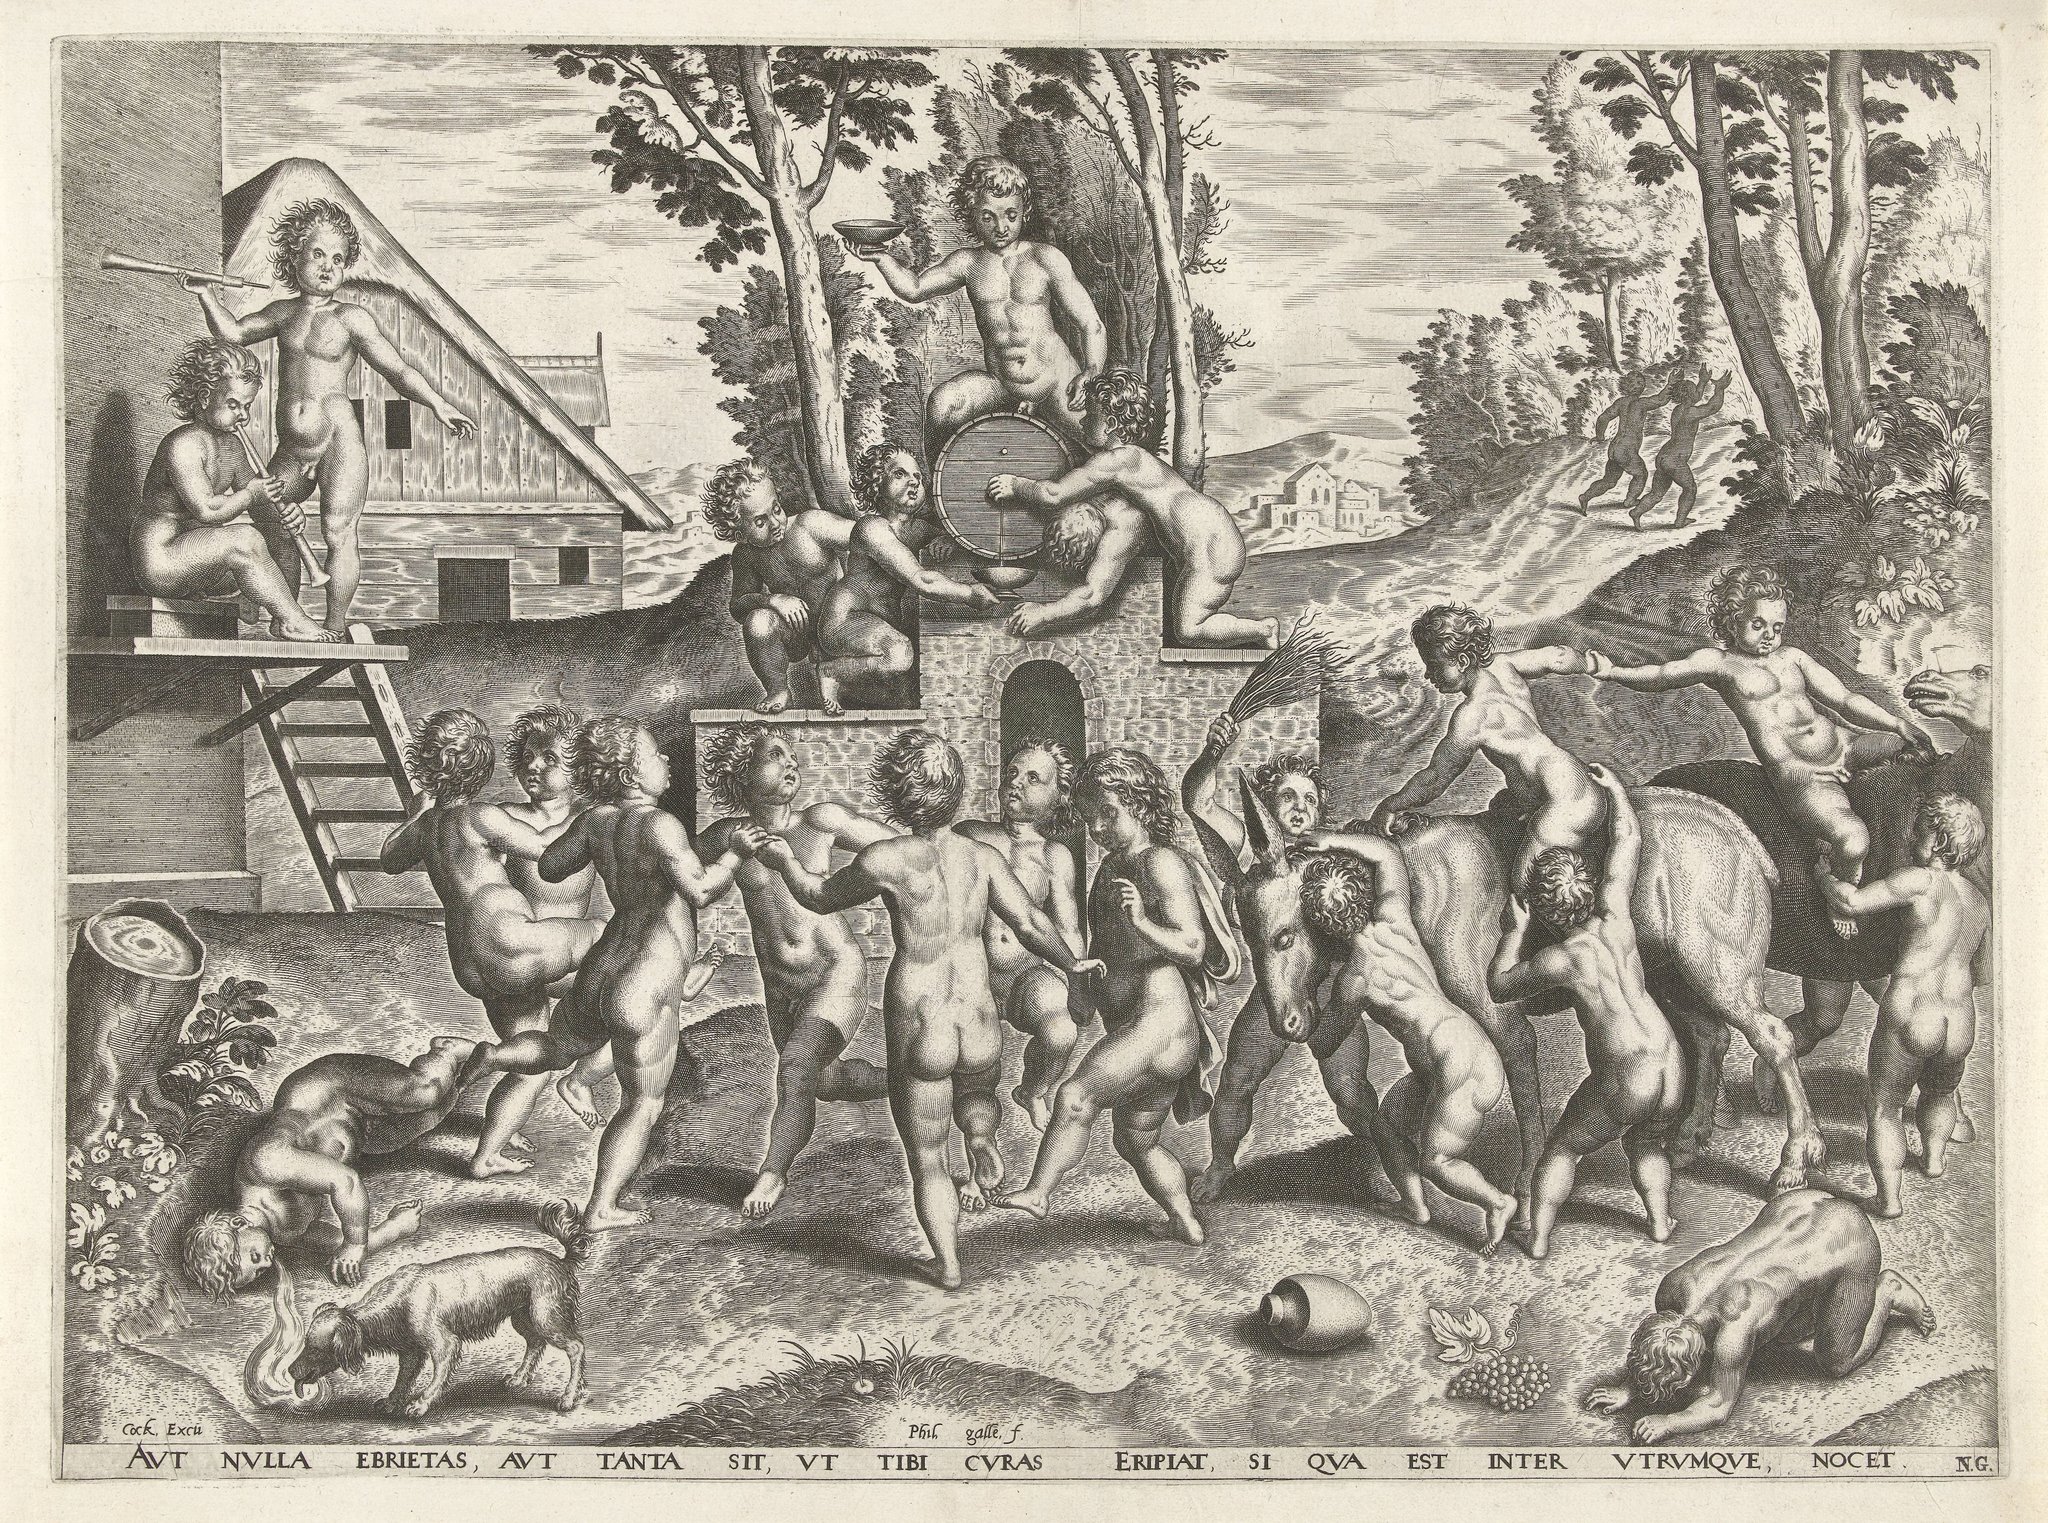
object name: print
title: Bacchanaal van kinderen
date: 1547-1570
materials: paper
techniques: engraving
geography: antwerp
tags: children's bacchanal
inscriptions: collector's mark: Lugt 2228, collector's mark: Lugt 1967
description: Centraal dansen verschillende kinderen in het rond. Anderen zitten op een ezel en spelen een spel. Enkele kinderen spelen muziek. In de achtergrond zit Bacchus, afgebeeld als kind, op zijn kenmerkende wijnton. In zijn hand een schaal wijn. Kinderen verdringen elkaar om als eerste uit de wijnton drank te tappen. De prent heeft een Latijns onderschrift.